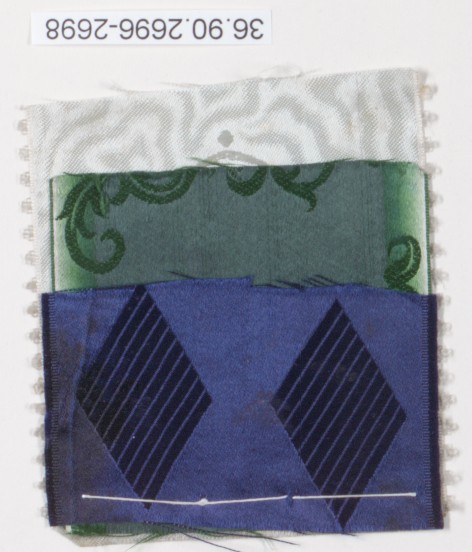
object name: ribbon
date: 1801-1900